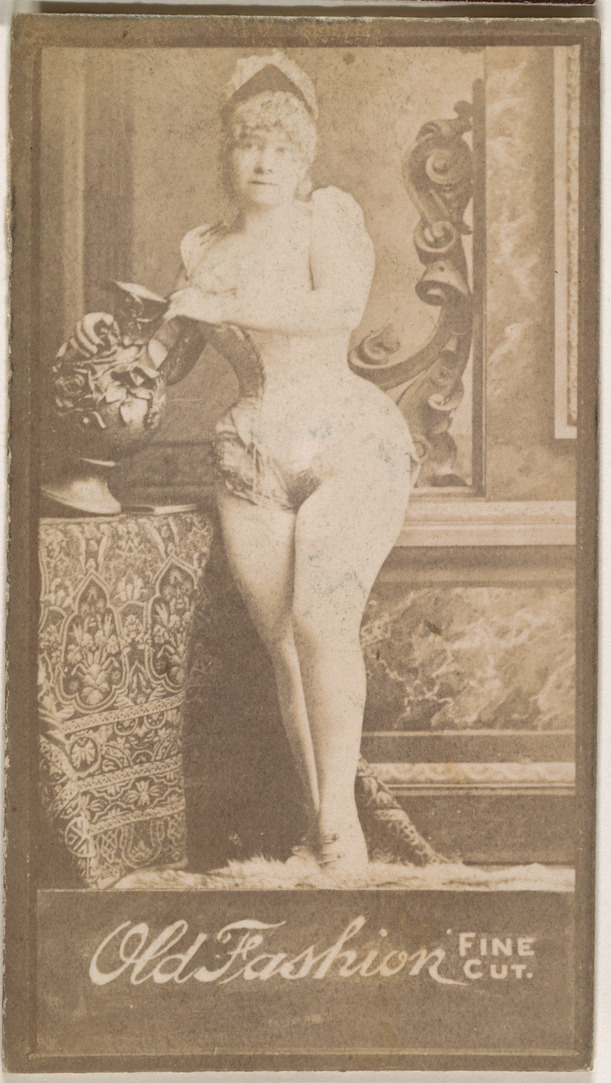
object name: photograph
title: Actress holding vase, from the Actresses series (N664) promoting Old Fashion Fine Cut Tobacco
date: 1888-1890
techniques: albumen silver print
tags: portraits,women,actresses